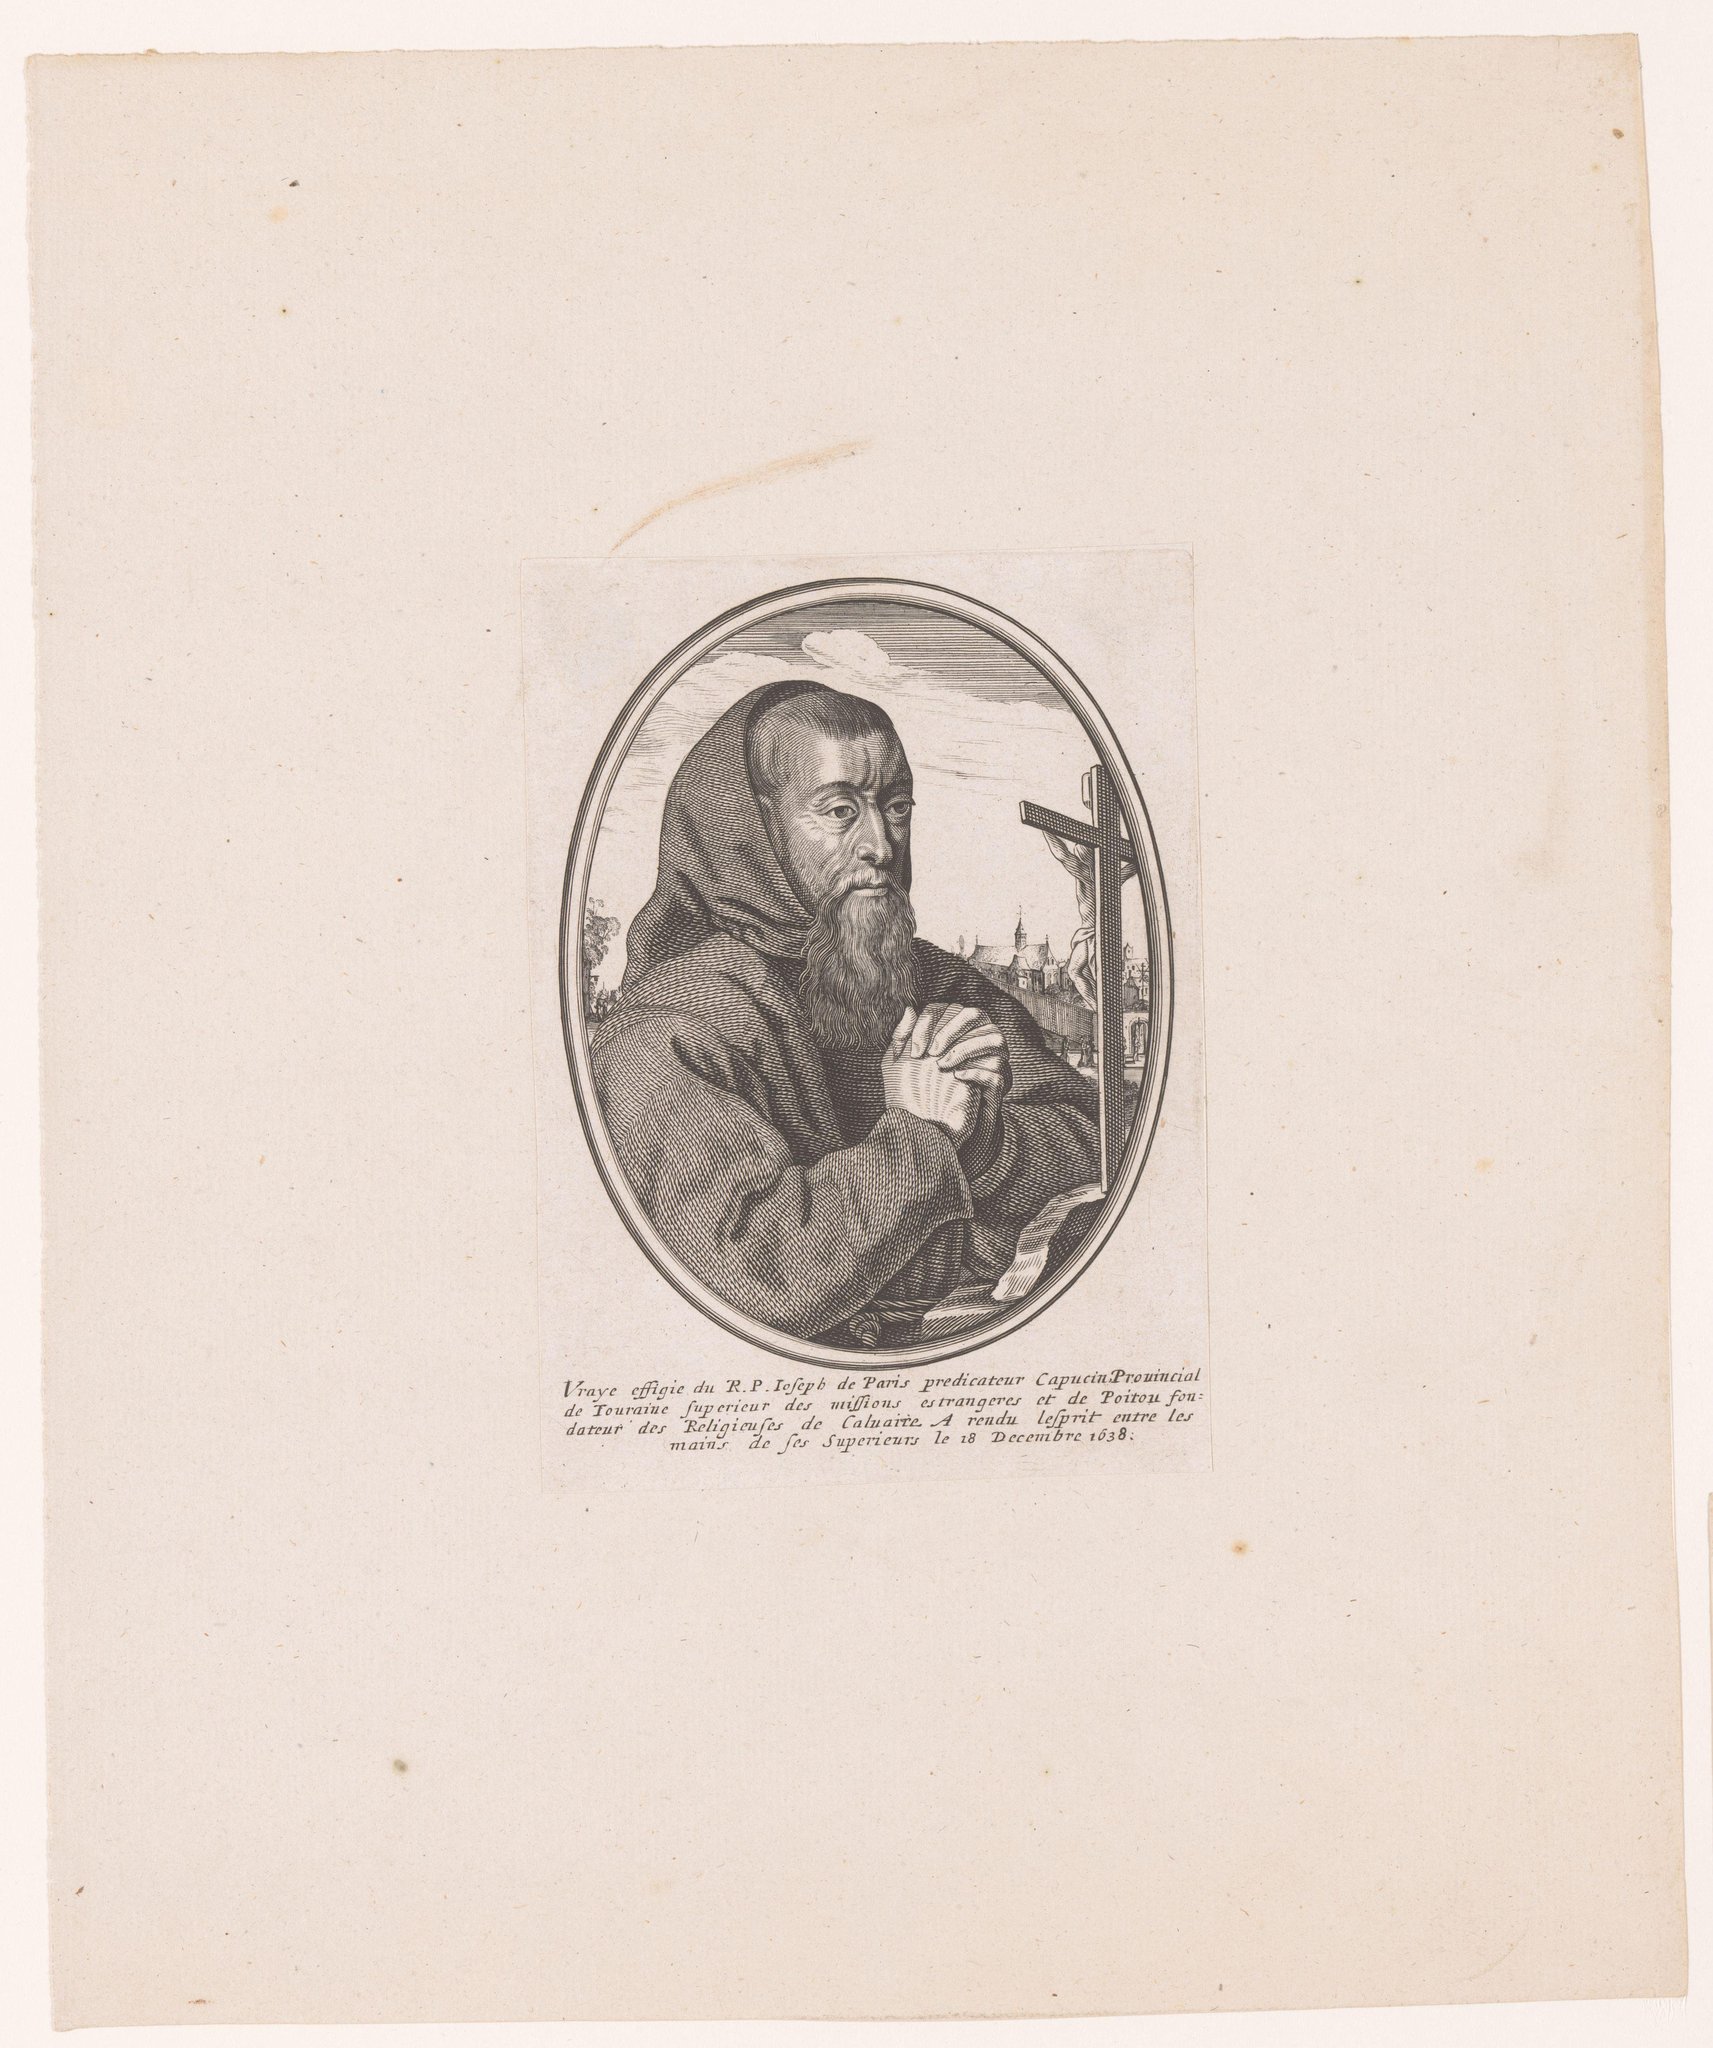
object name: print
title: Portret van François Leclerc du Tremblay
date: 1638-1668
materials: paper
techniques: engraving, etching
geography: paris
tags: historical persons, monk(s), friar(s)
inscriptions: collector's mark: Lugt 2228